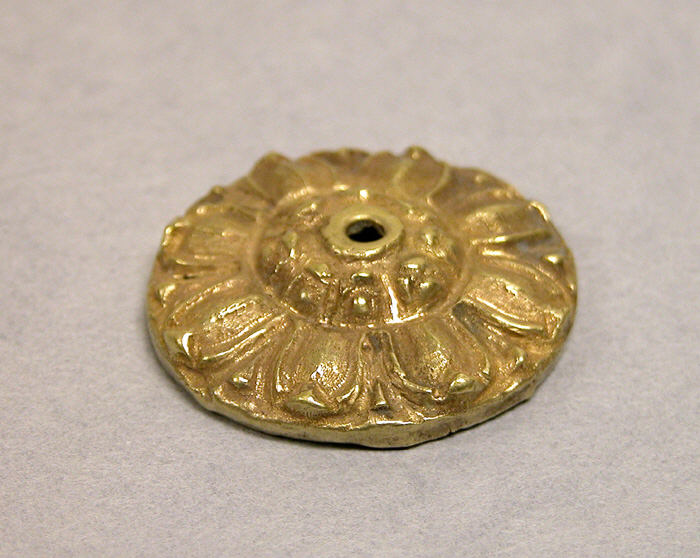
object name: ornament pyxis lid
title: Ornament: pyxis lid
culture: indonesian, central java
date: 701-1200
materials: gold